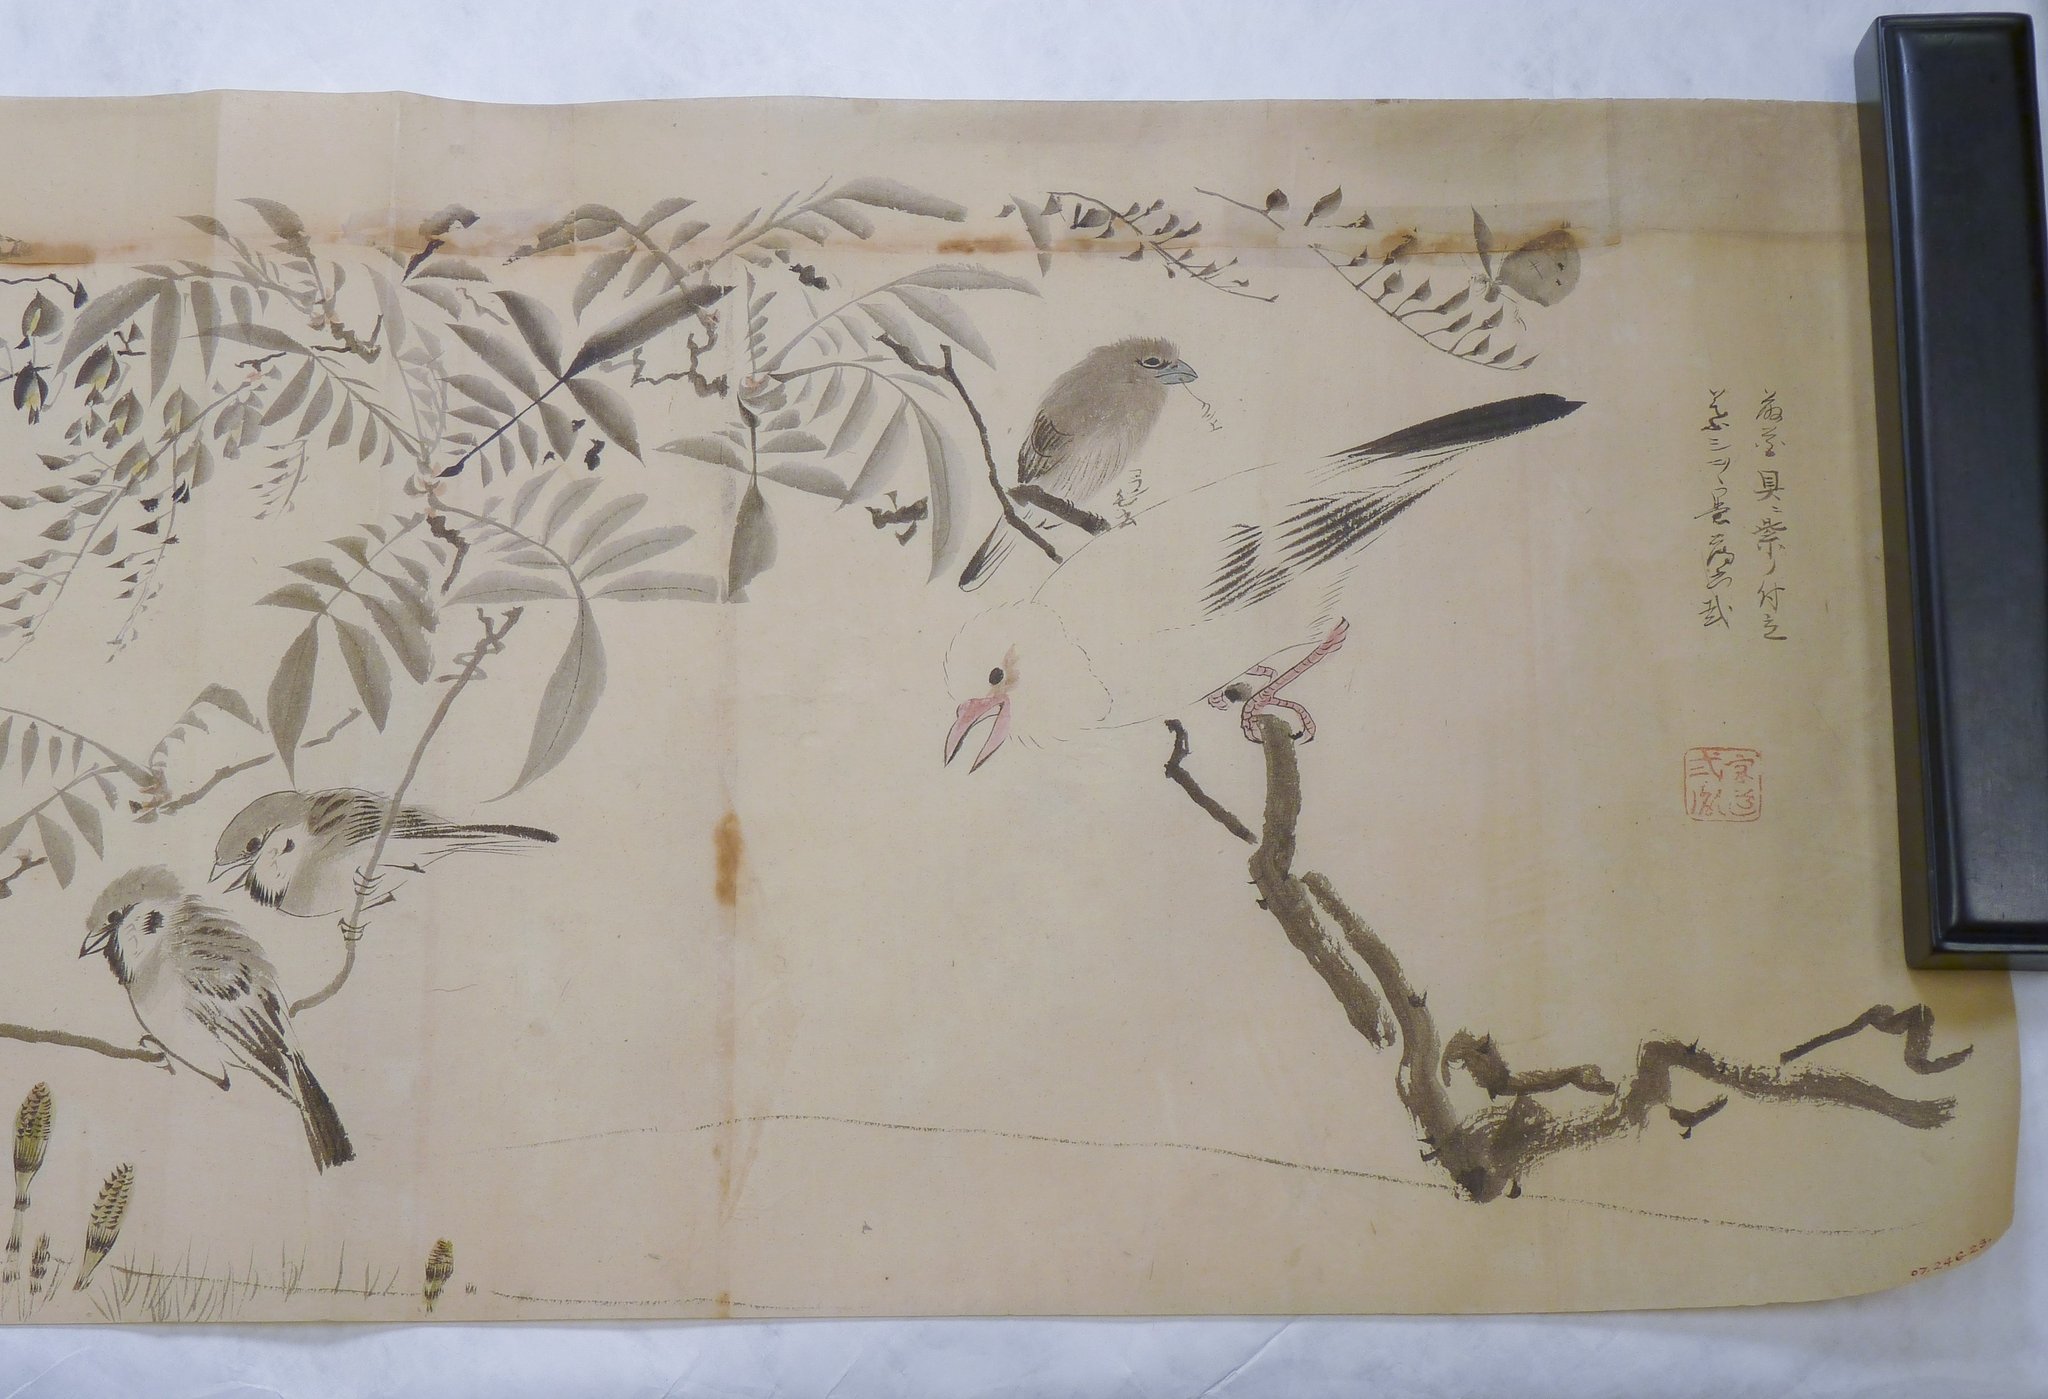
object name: drawing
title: Japanese Drawing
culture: japanese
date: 1801-1833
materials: paper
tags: birds,leaves